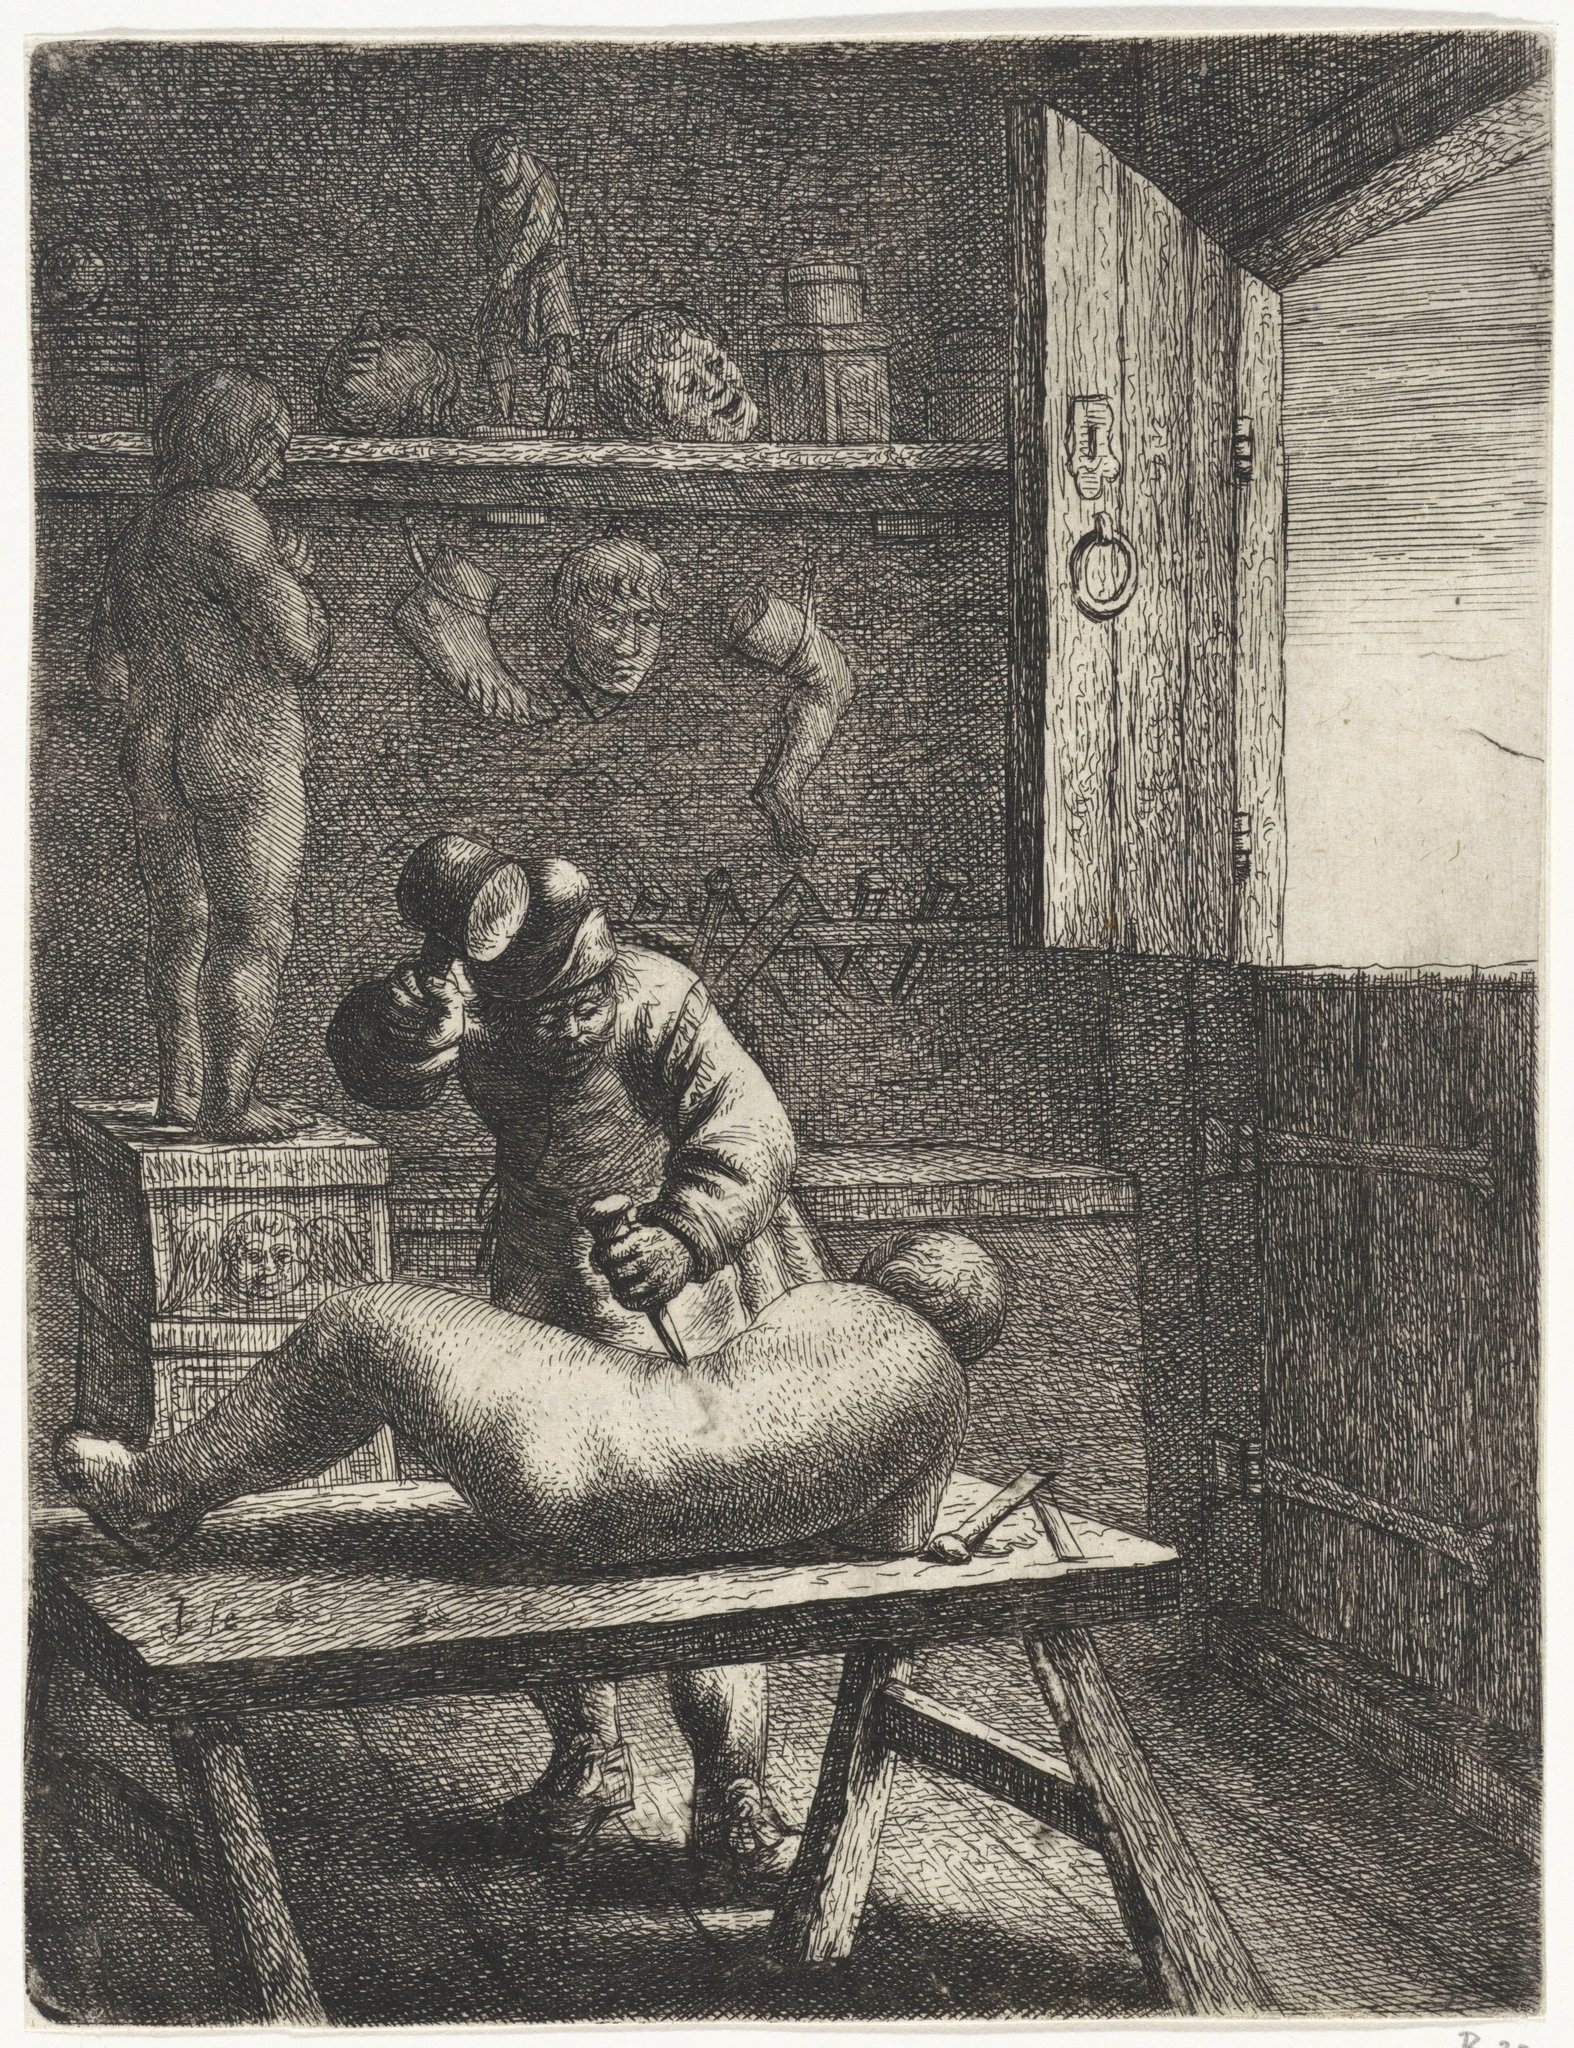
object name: print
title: Beroepen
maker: jan gillisz. van vliet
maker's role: draughtsman, painter, print maker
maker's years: 1600-1668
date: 1635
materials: paper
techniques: etching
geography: leiden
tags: tools, aids, implements ~ crafts and industries: chisel, tools, implements of sculptor: mallet, sculptor at work, divided door, upper part opened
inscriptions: collector's mark: Lugt 240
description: Een beeldhouwer in zijn atelier, terwijl hij met hamer en beitel een beeld bewerkt van een liggende figuur. Rechts een openstaande bovendeur.